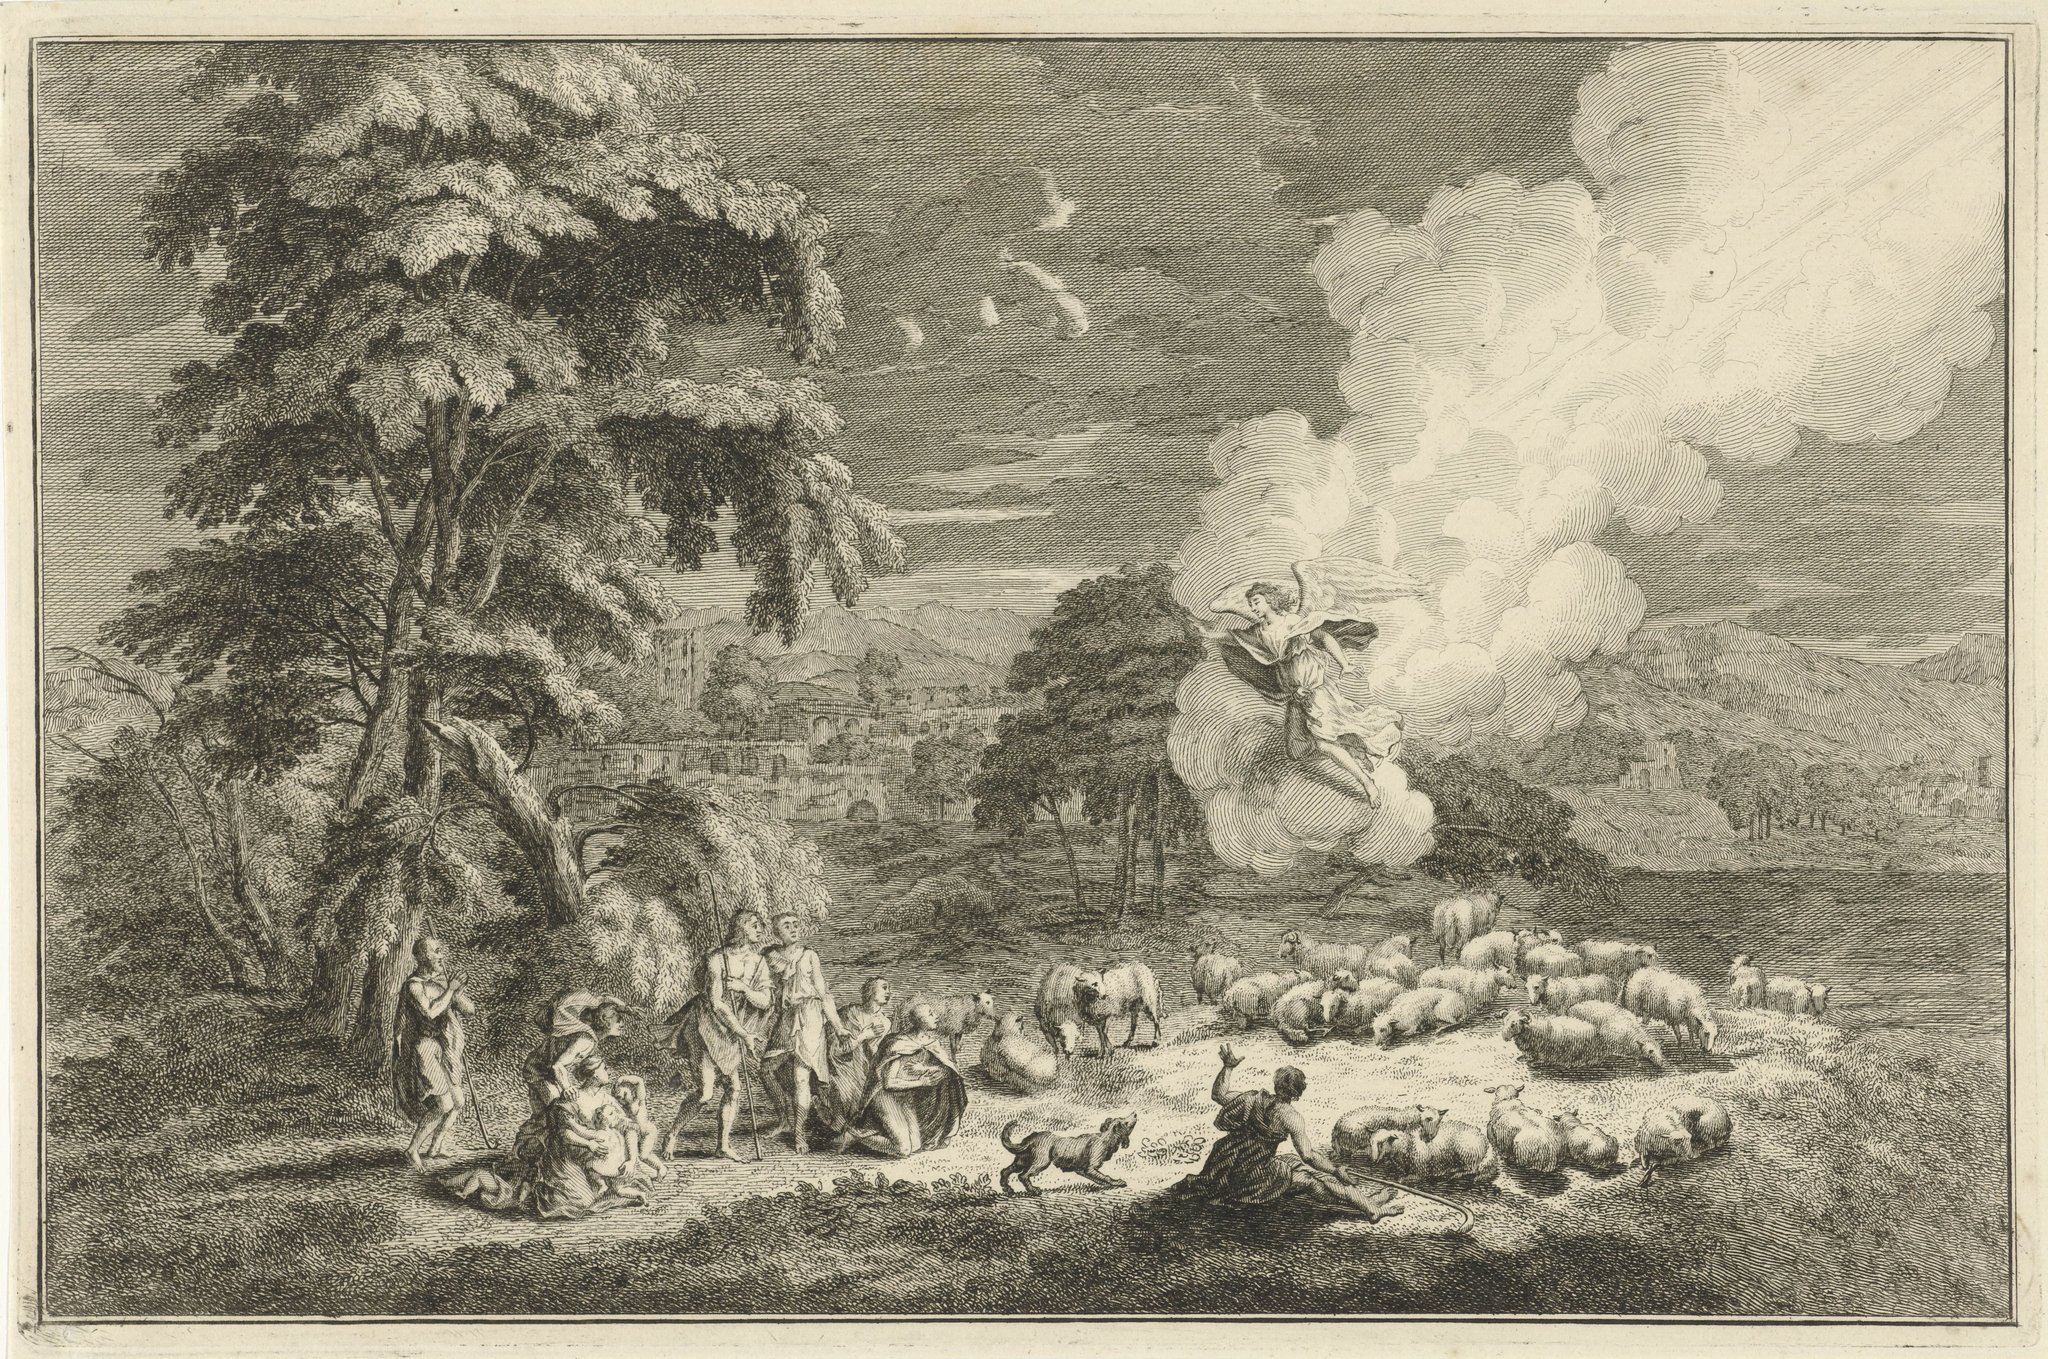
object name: print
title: Italiaanse en Duitse landschappen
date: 1710-1747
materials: paper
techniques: etching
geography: amsterdam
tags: annunciation of christ's birth to the shepherds (and/or shepherdesses) at night; a host of singing angels in the air, landscapes with waters, waterscapes, seascapes (in the temperate zone)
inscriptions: collector's mark: Lugt 240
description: Landschap met de verkondiging aan de herders. De prent maakt deel uit van een 40-delige serie prenten met voorstellingen van Italiaanse en Duitse landschappen.